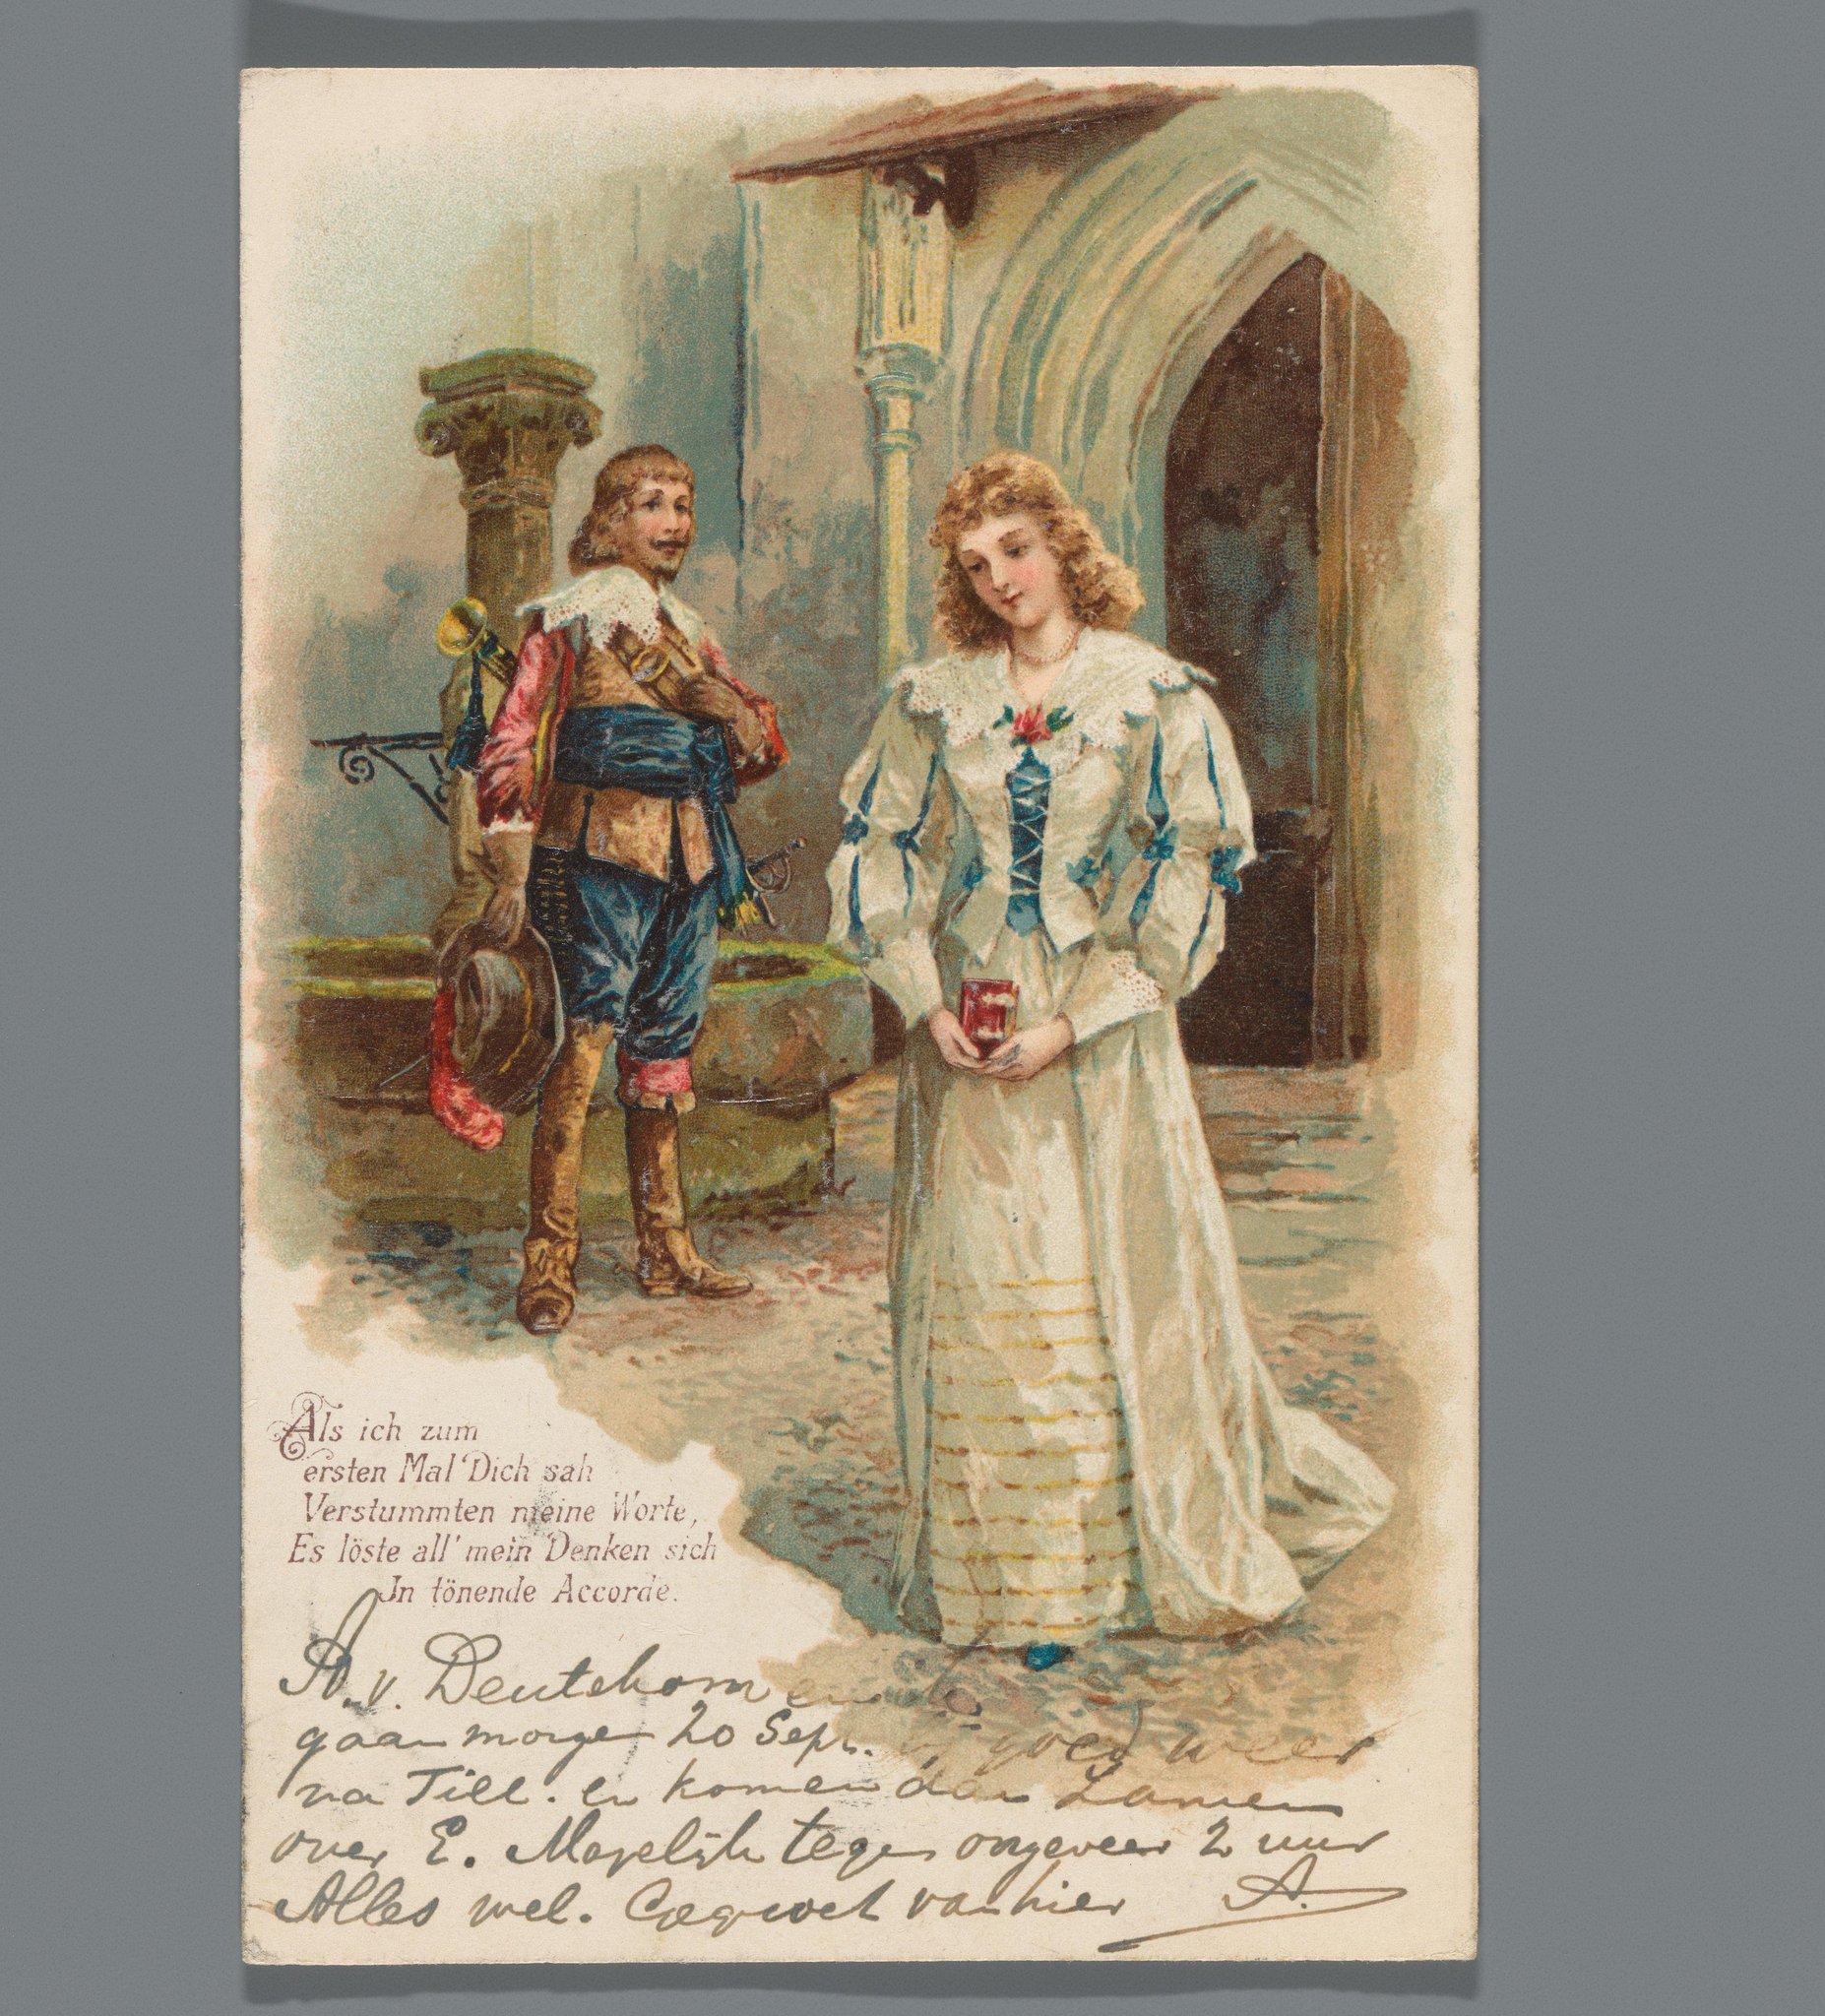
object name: ansichtkaart, prentbriefkaart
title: Verloofd stel voor een portaal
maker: Anonymous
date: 1903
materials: paper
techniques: blind stamped, lithograph, writing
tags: betrothal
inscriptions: number: ‘Serie 2812’